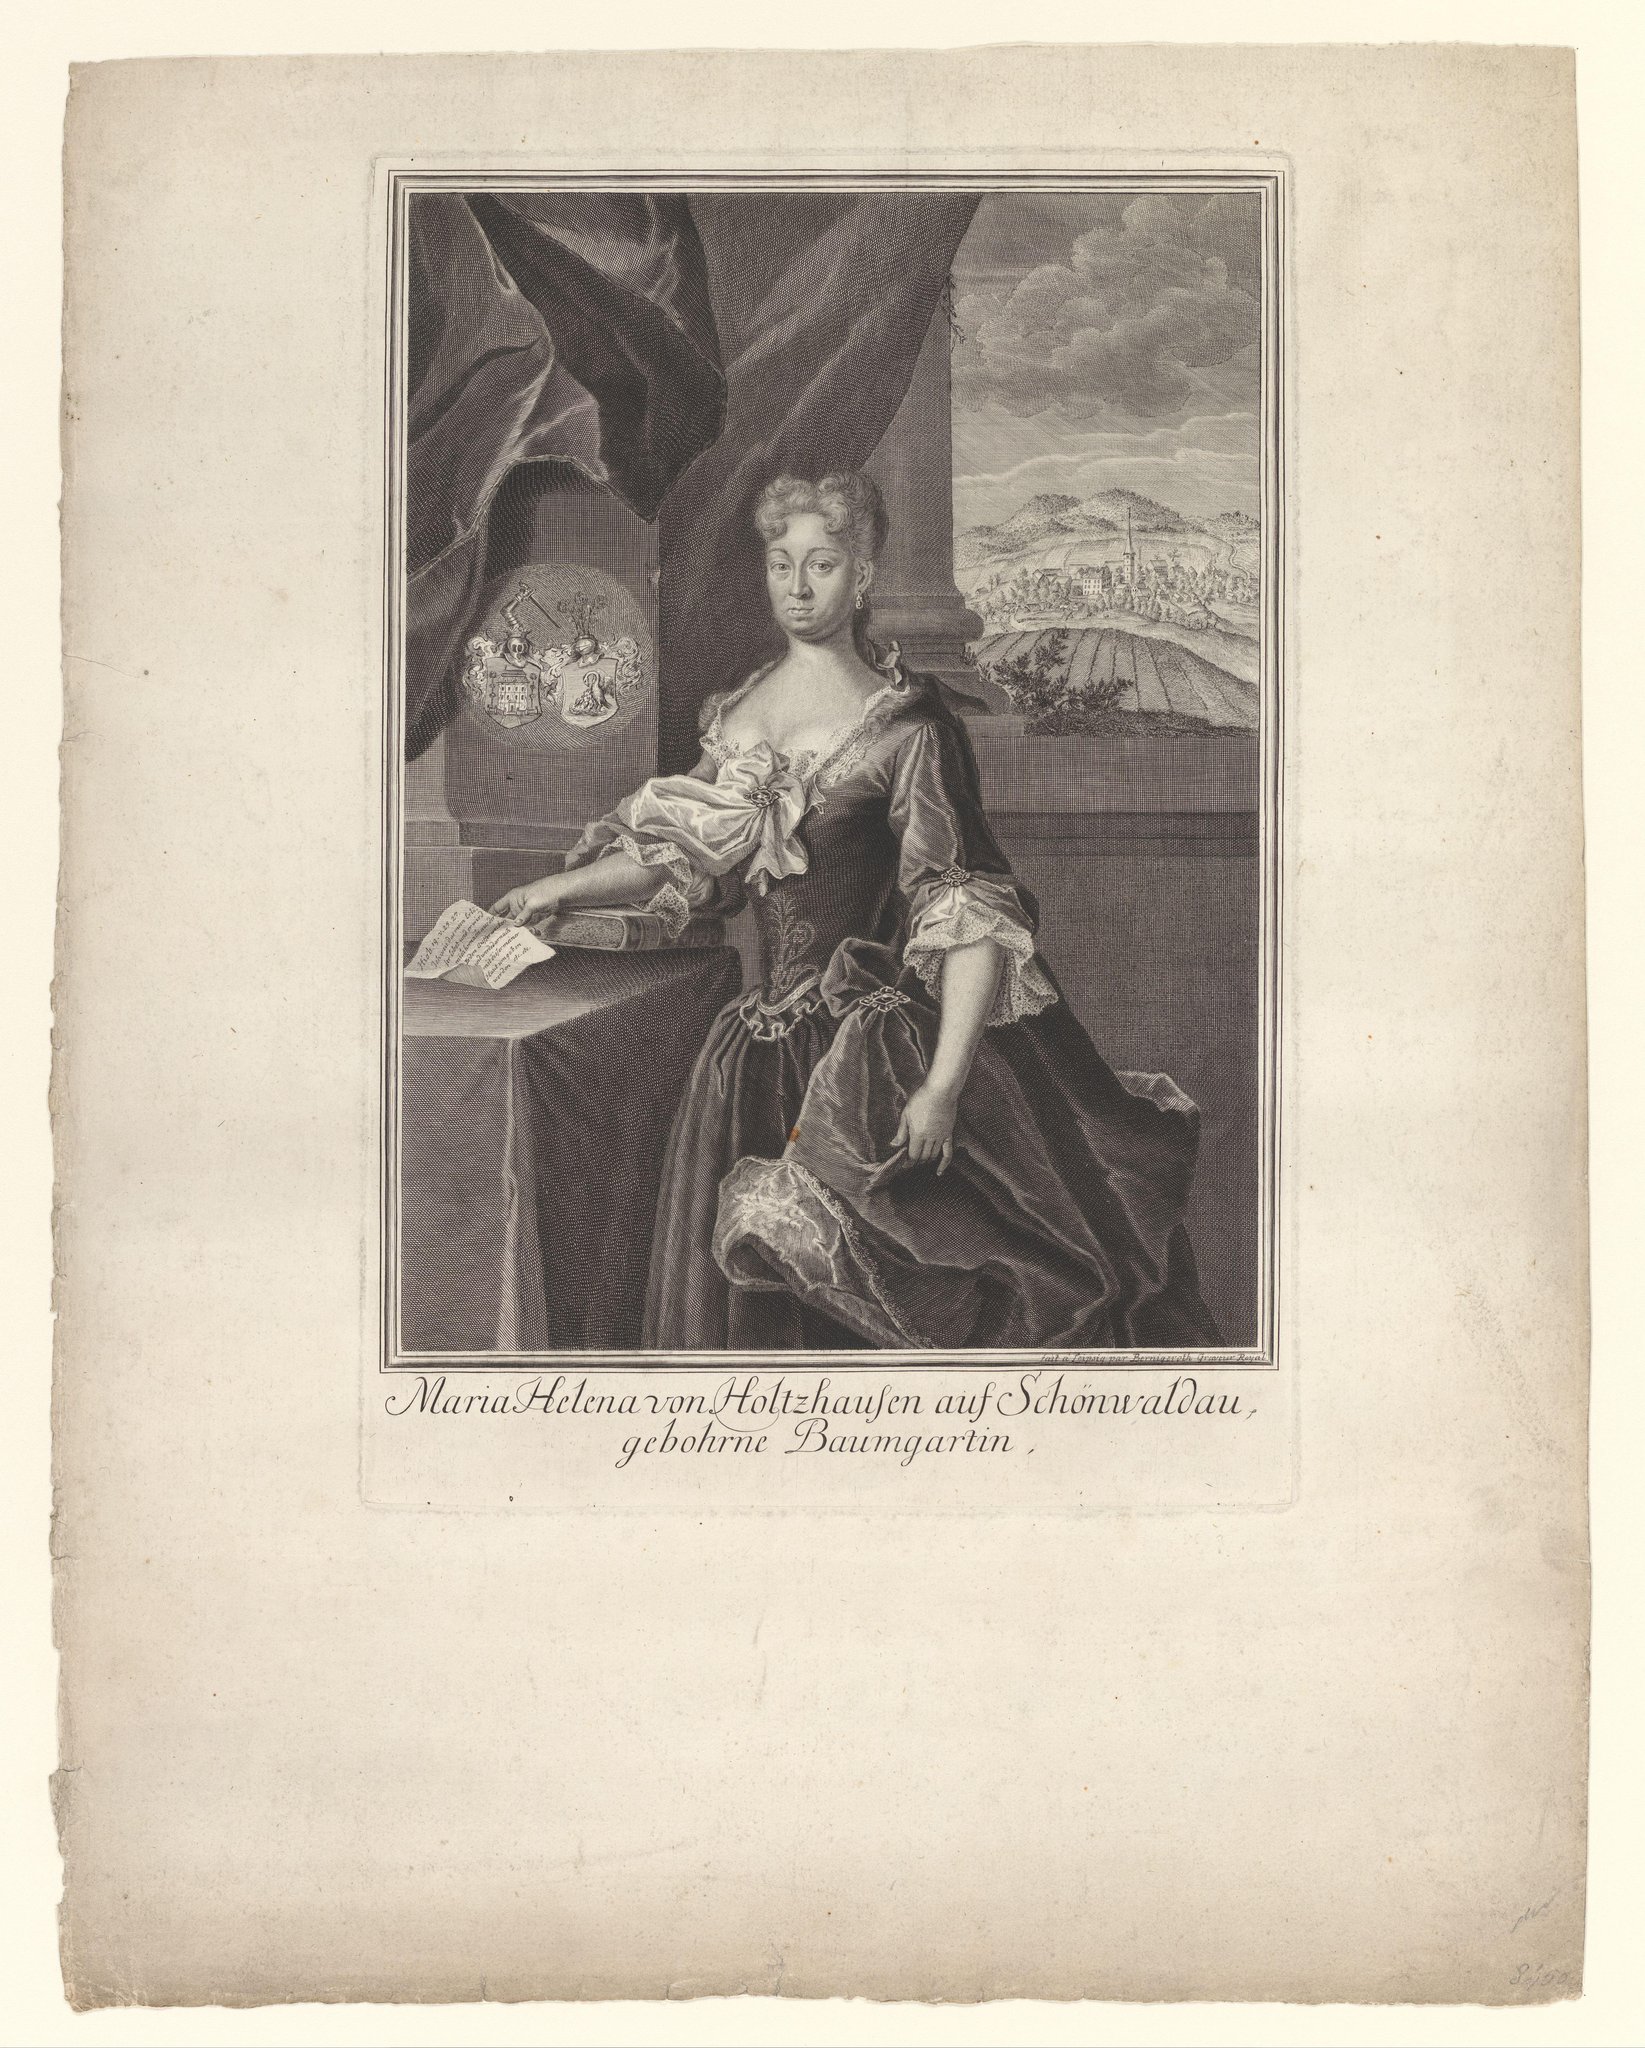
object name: print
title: Portret van Maria Helena von Holzhausen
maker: johann martin bernigeroth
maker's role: print maker, publisher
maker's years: 1713-1767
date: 1723-1767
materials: paper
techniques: engraving, etching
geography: leipzig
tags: historical persons - bb - woman, armorial bearing, heraldry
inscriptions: collector's mark: Lugt 2228